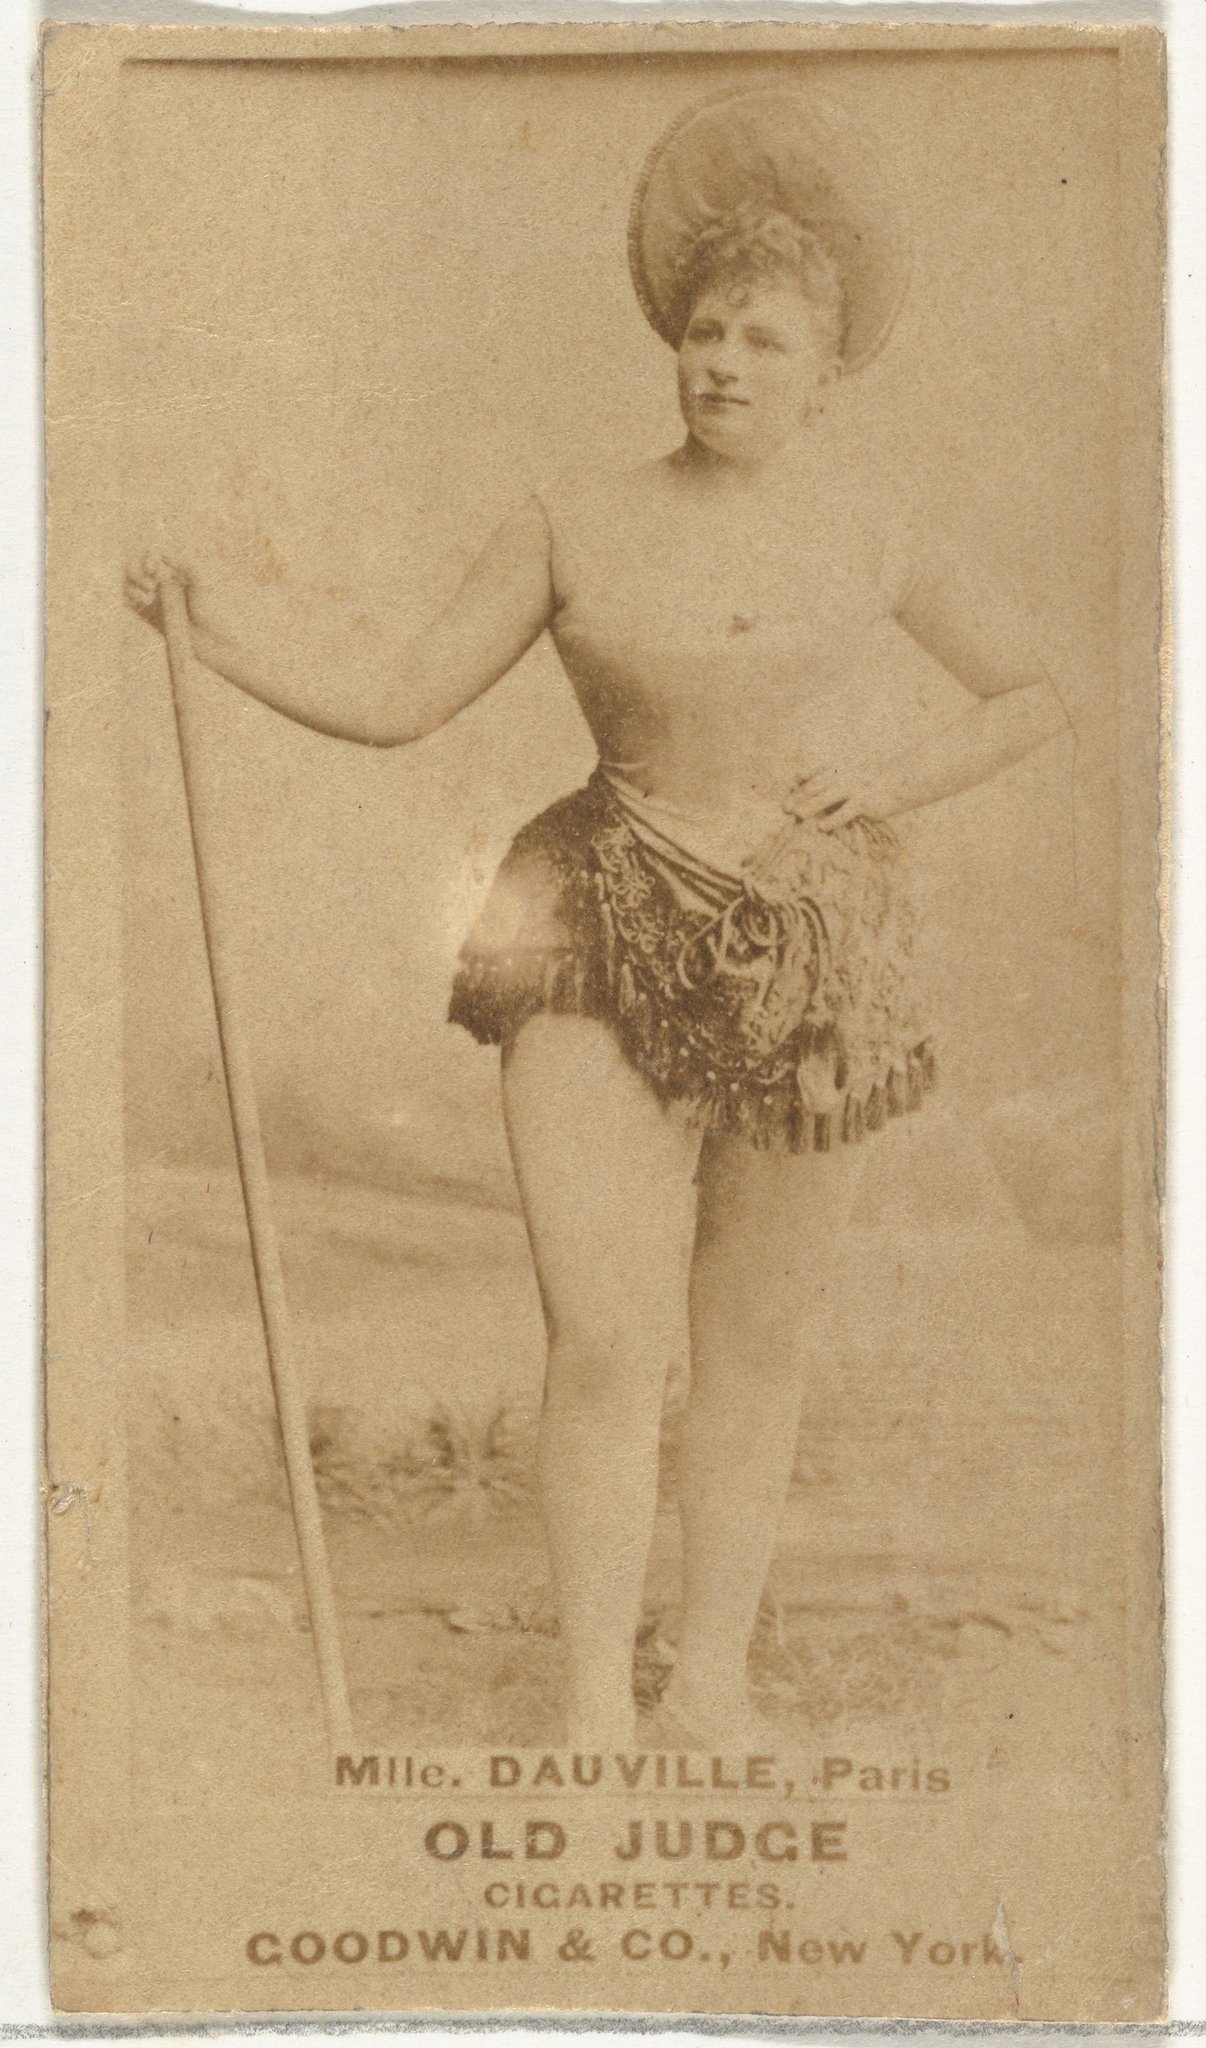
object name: photograph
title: Mlle. Dauville, Paris, from the Actors and Actresses series (N171) for Old Judge Cigarettes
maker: goodwin & company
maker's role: publisher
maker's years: 1850-1950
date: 1886-1890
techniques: albumen silver print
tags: portraits,women,actresses